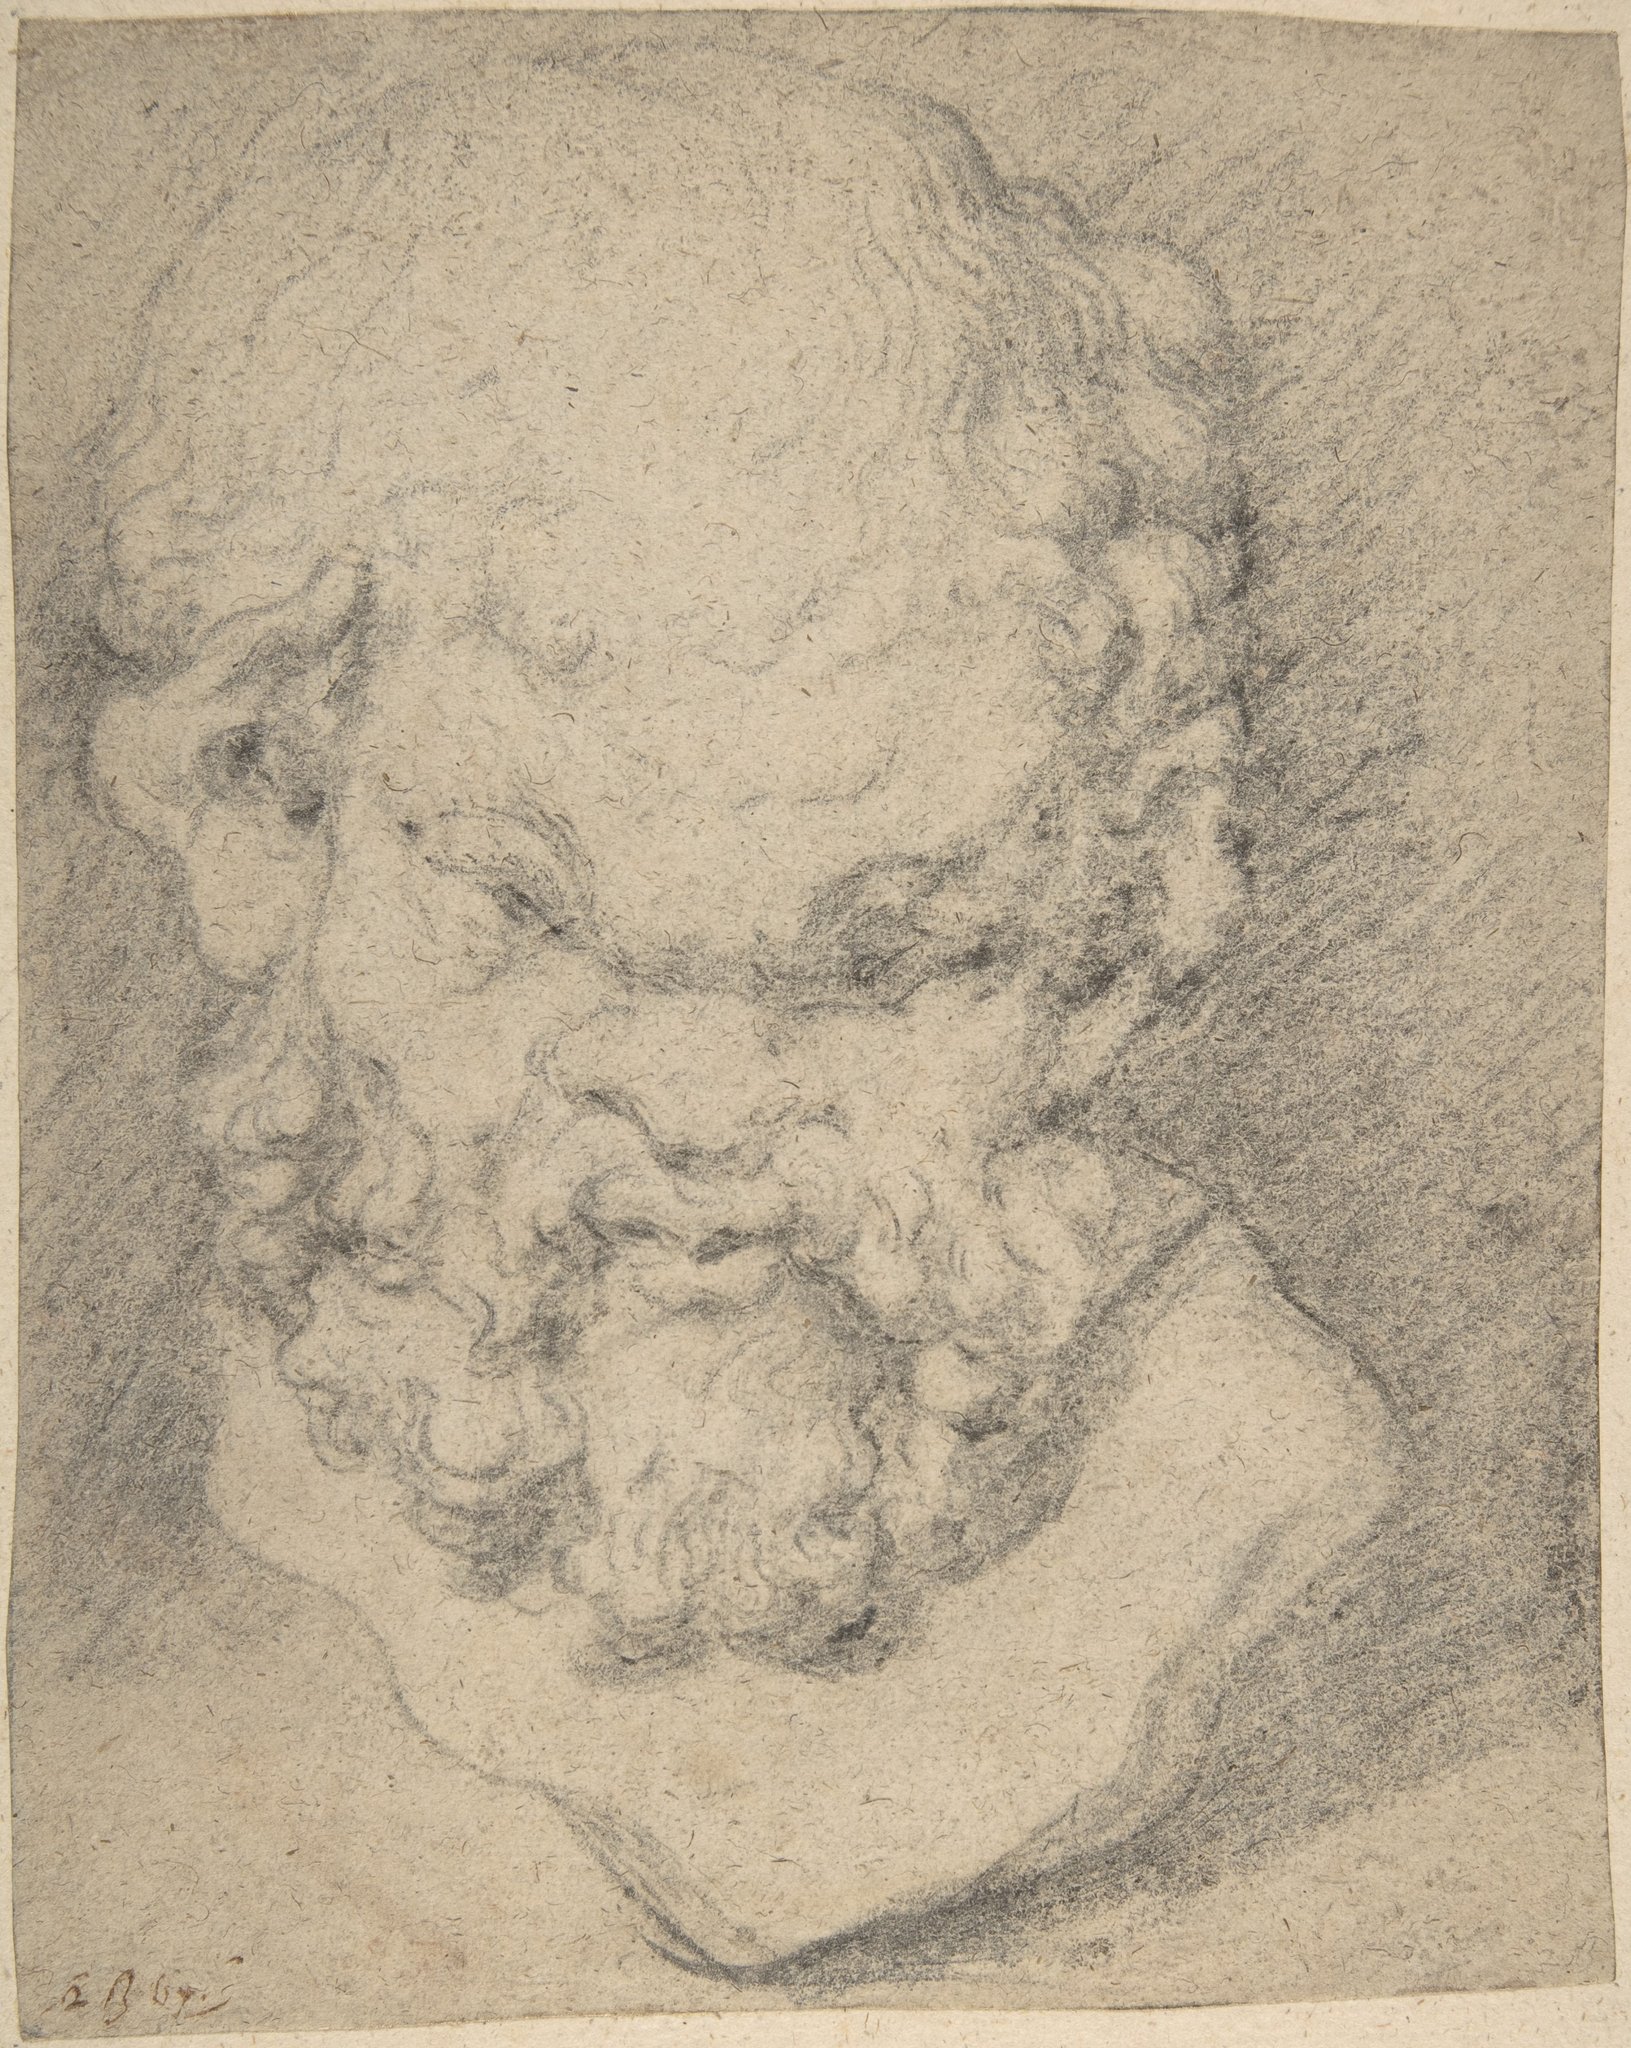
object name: drawing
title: Head of Silenus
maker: peter paul rubens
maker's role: artist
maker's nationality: flemish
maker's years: 1577-1640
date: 1601-1633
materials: chalk, paper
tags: heads,silenus